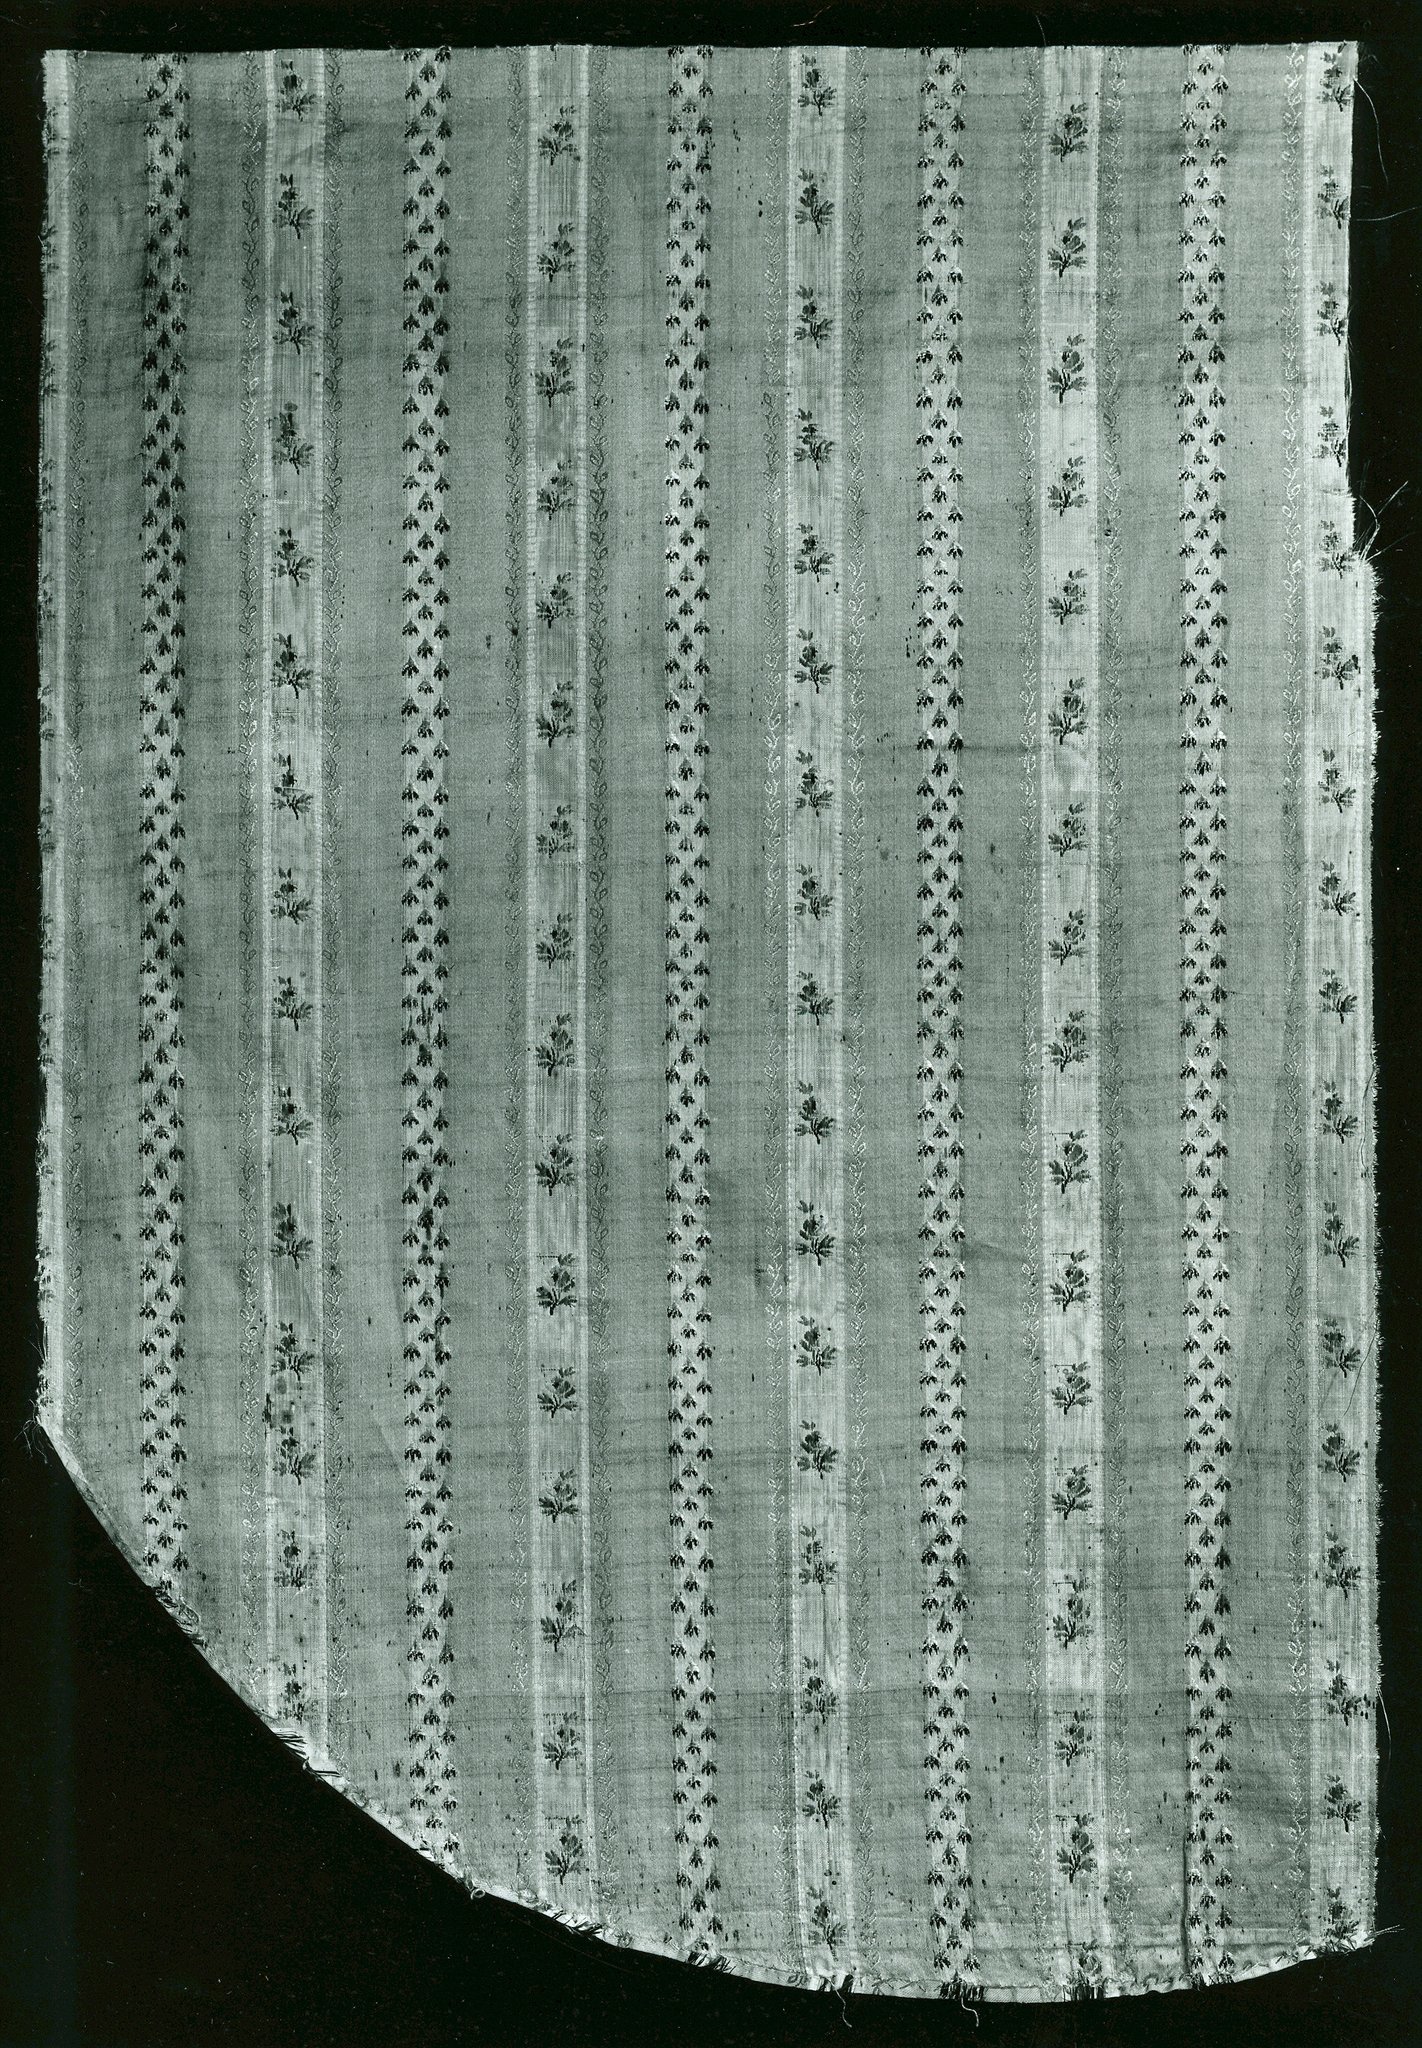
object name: textile fragment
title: Fragment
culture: spanish or valencian or talavera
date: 1767-1800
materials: silk